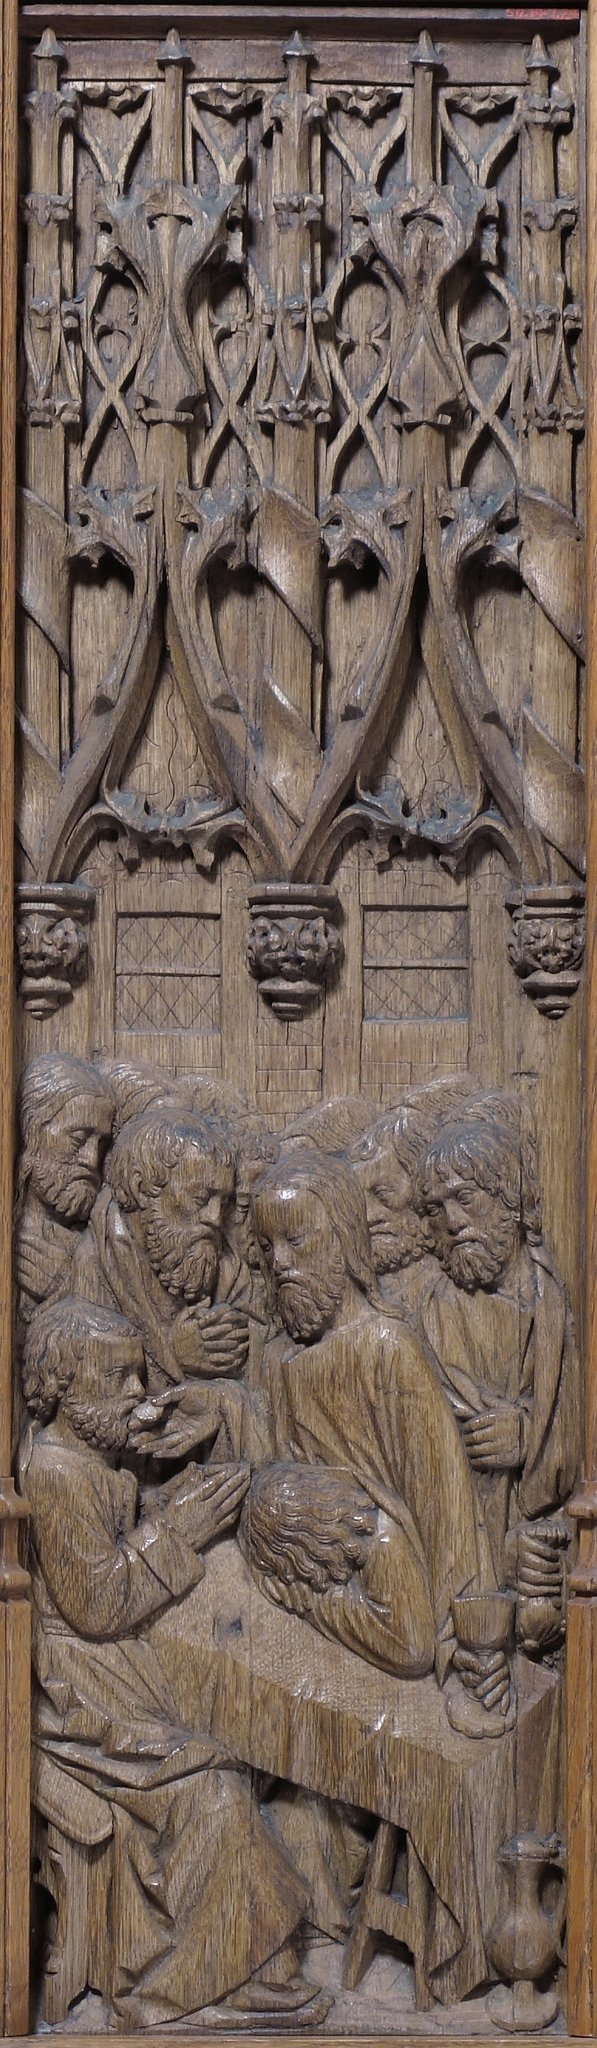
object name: panel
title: Panel with the Last Supper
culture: french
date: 1501-1533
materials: wood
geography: france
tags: apostles,jesus,last supper